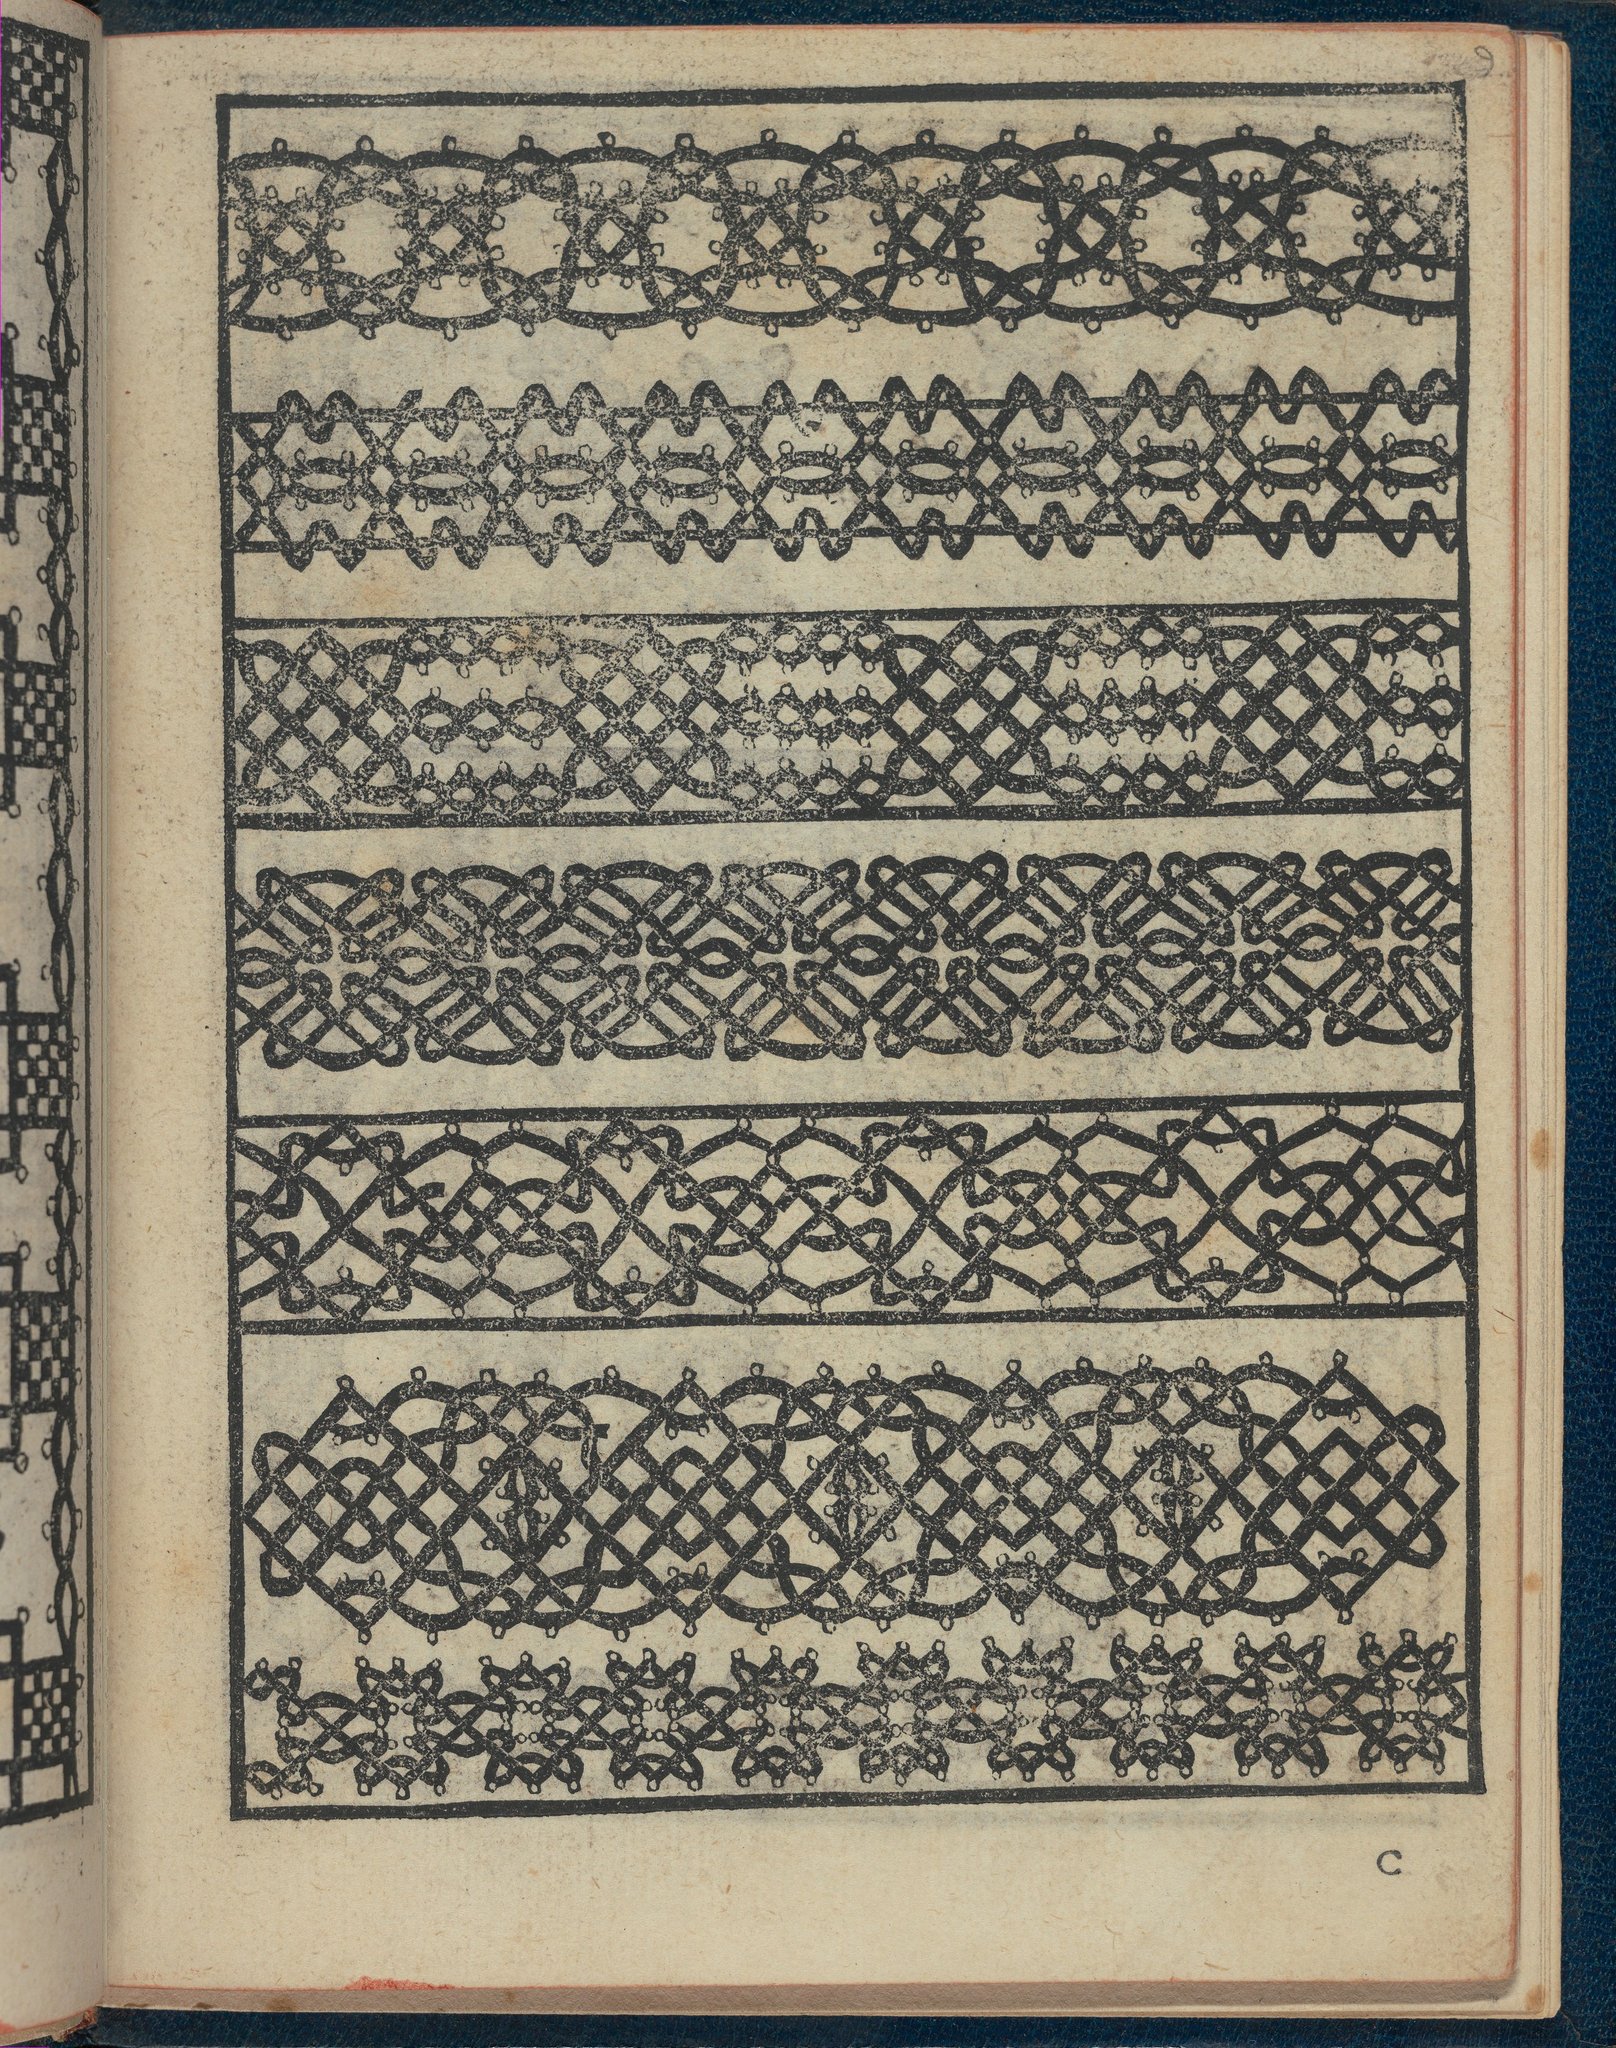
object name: book print ornament architecture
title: Le Pompe: Opera Nova, page 5 (recto)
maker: giovanni battista & marchio sessa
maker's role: publisher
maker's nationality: italian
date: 1557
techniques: woodcut